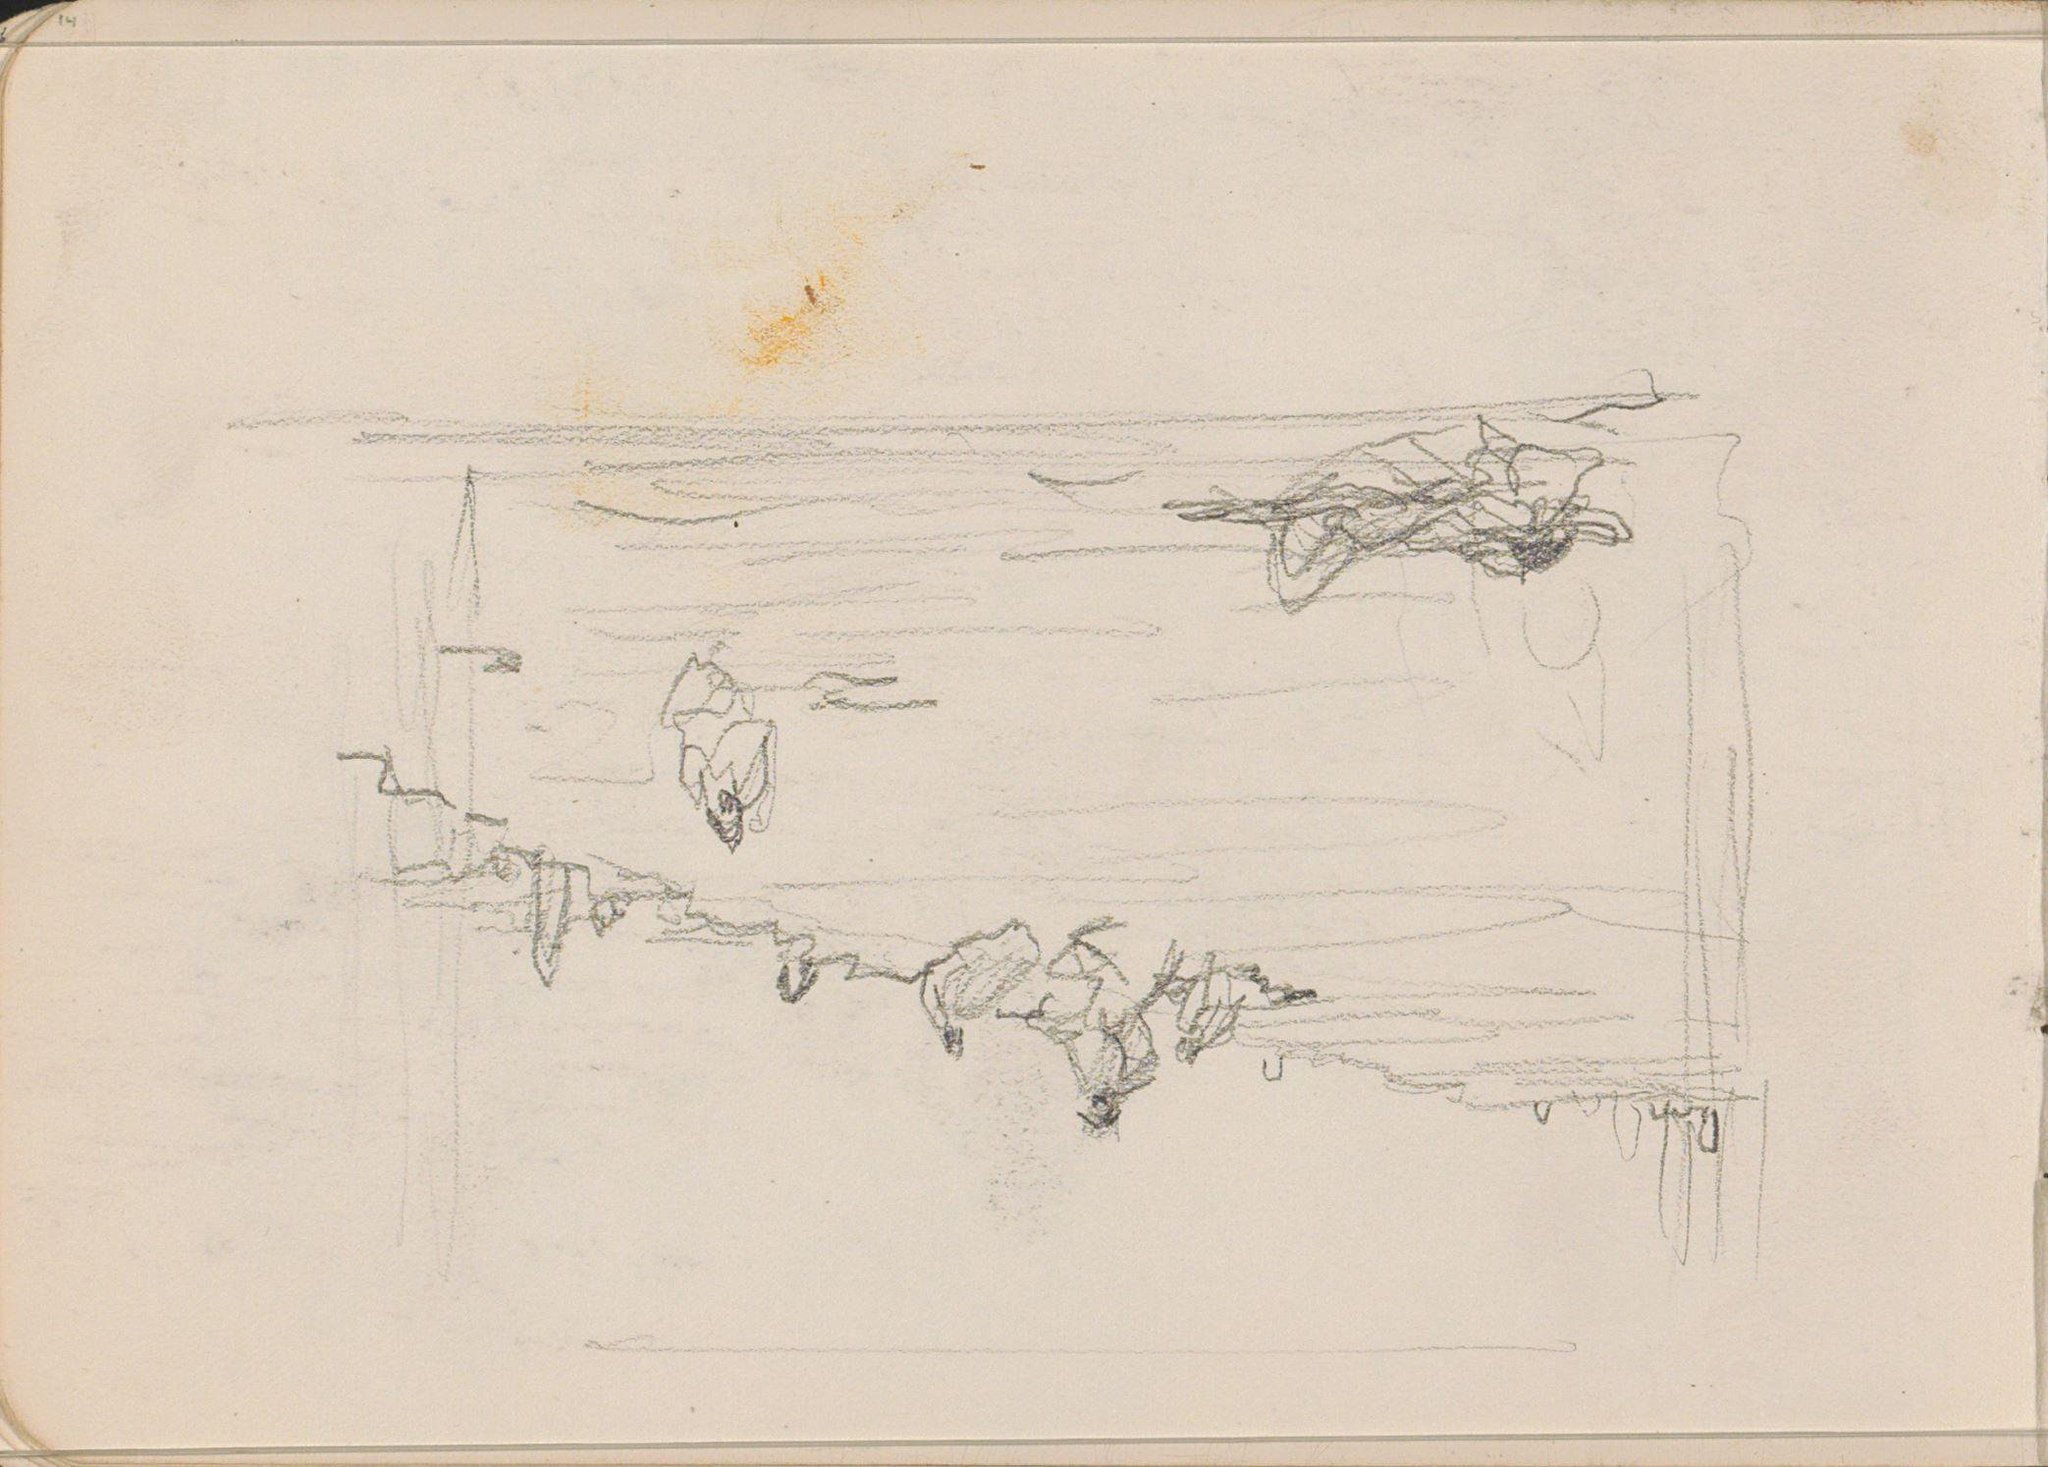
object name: sketchbook leaf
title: Zittende en liggende figuren op een trap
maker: marius bauer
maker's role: draughtsman, print maker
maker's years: 1867-1932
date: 1925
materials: paper, pencil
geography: india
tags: sitting figure, flight of steps, lying figure, asiatic races and peoples: indians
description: Pagina 14 uit een schetsboek met 15 bladen.